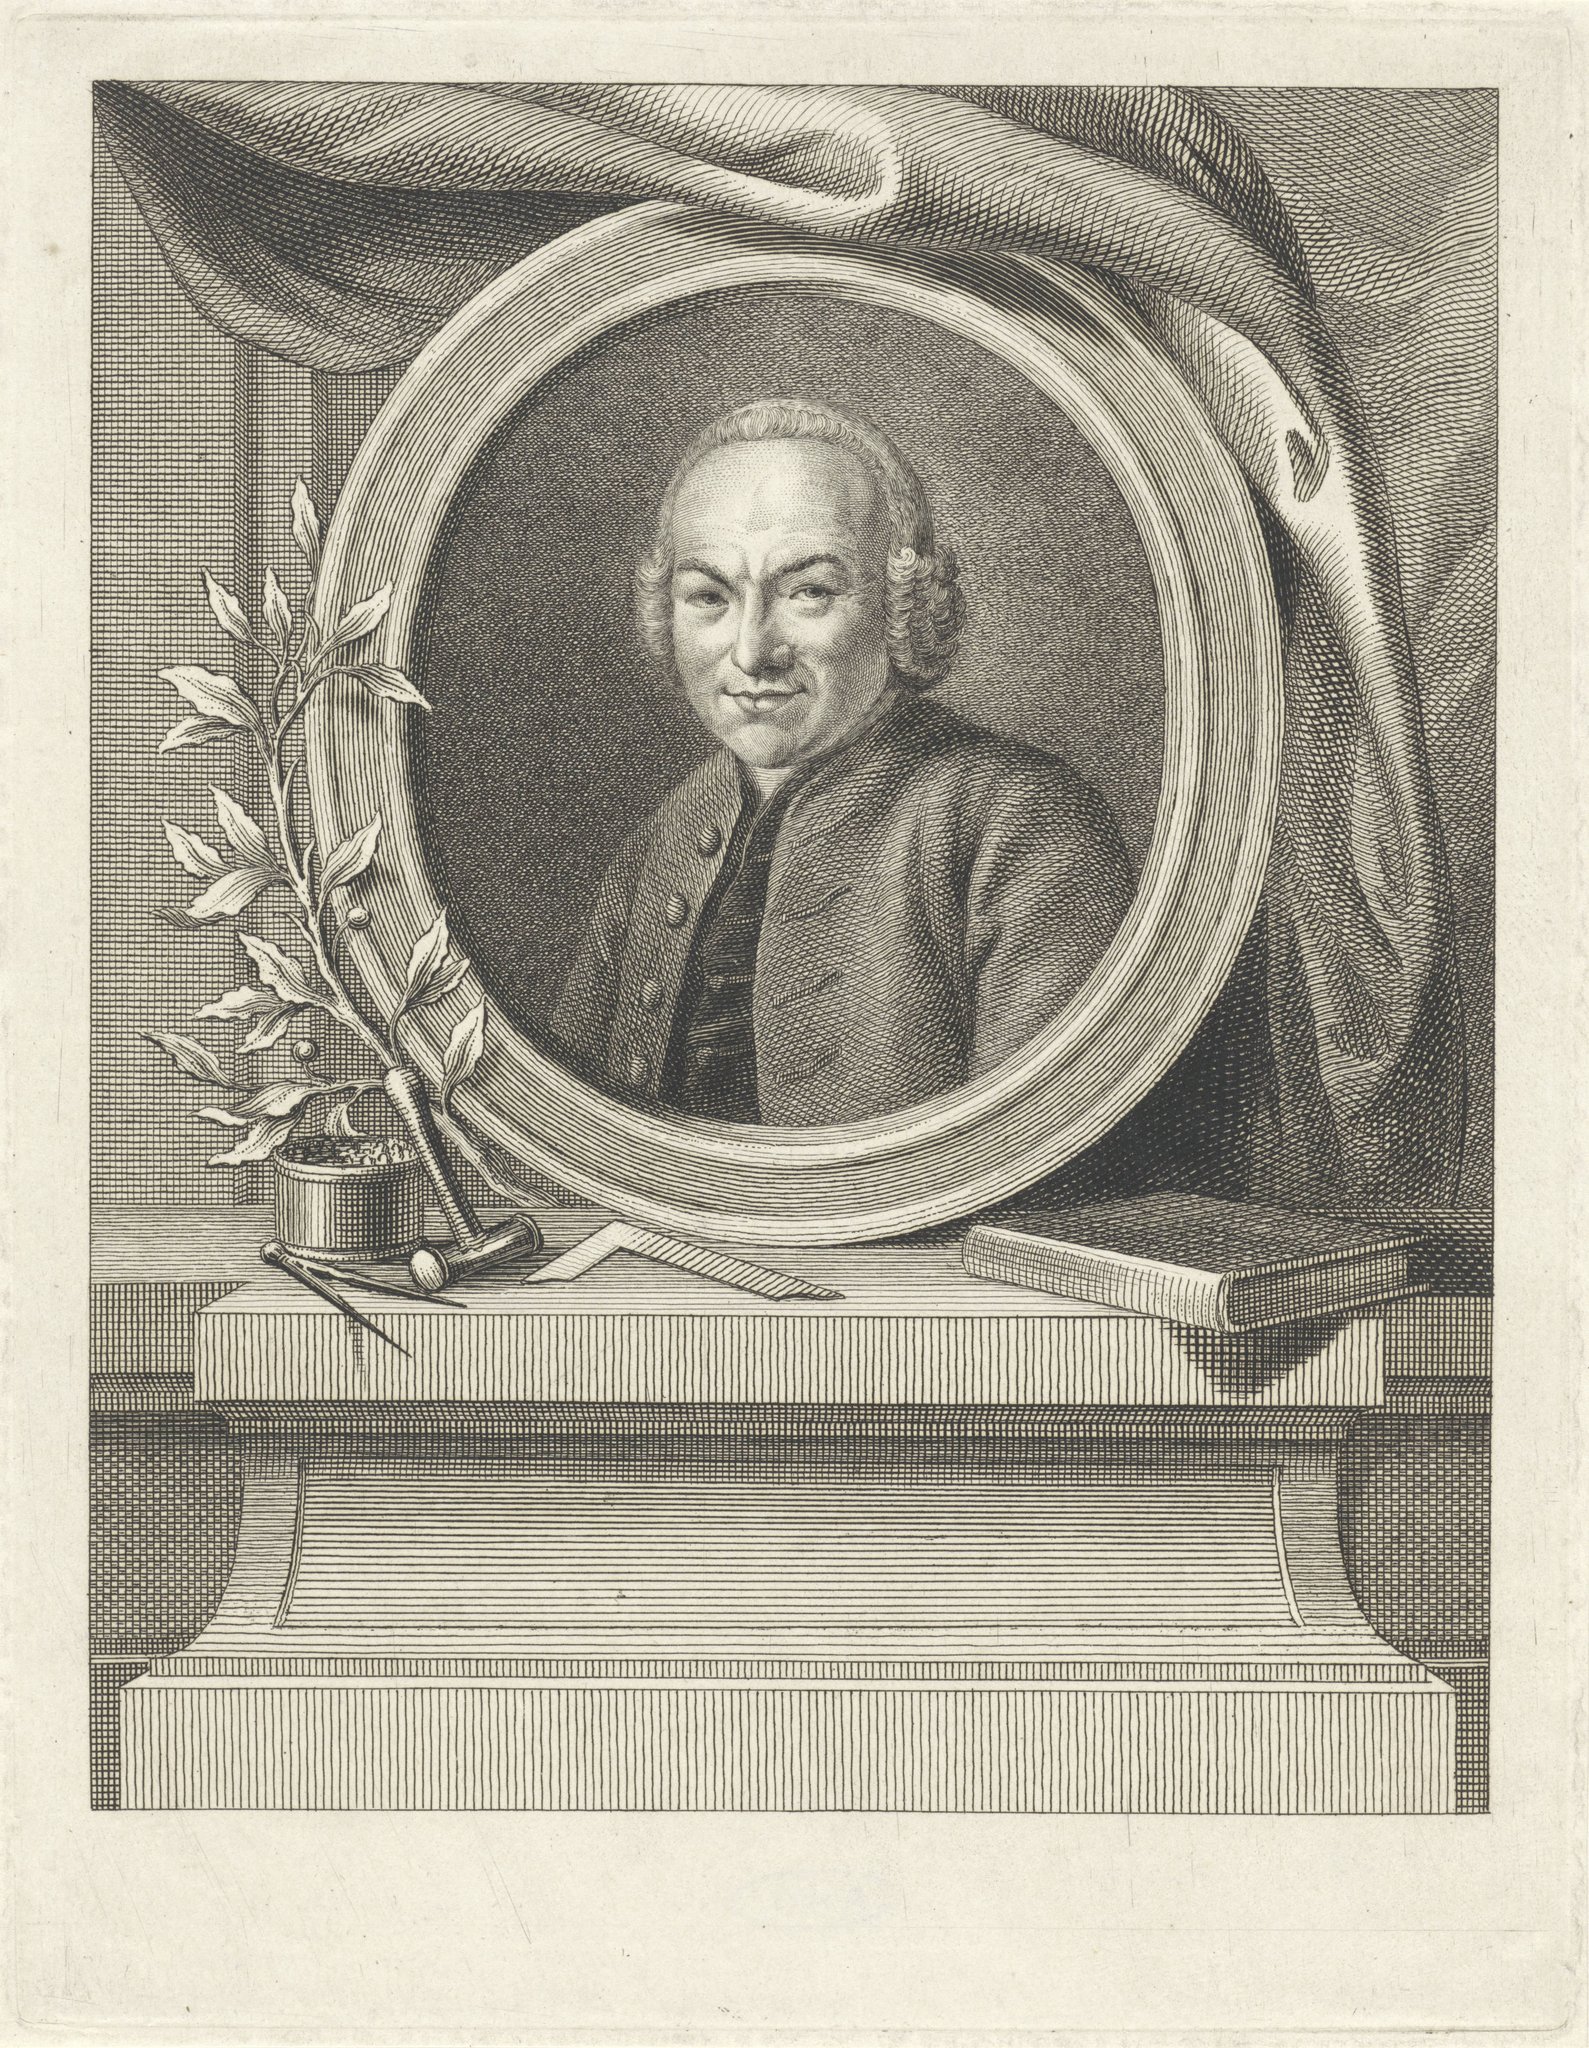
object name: print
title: Portret van Joan Michaël Fleischmann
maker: reinier vinkeles (i)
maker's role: draughtsman, print maker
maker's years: 1741-1816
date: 1768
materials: paper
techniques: engraving, etching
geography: amsterdam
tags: die cutter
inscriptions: collector's mark: Lugt 2228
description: Portret van Joan Michaël Fleischmann, lettersnijder en drukker te Haarlem. Op de sokkel liggen passer, winkelhaak, boek en hamer. Rechstboven: Bladz. 82.